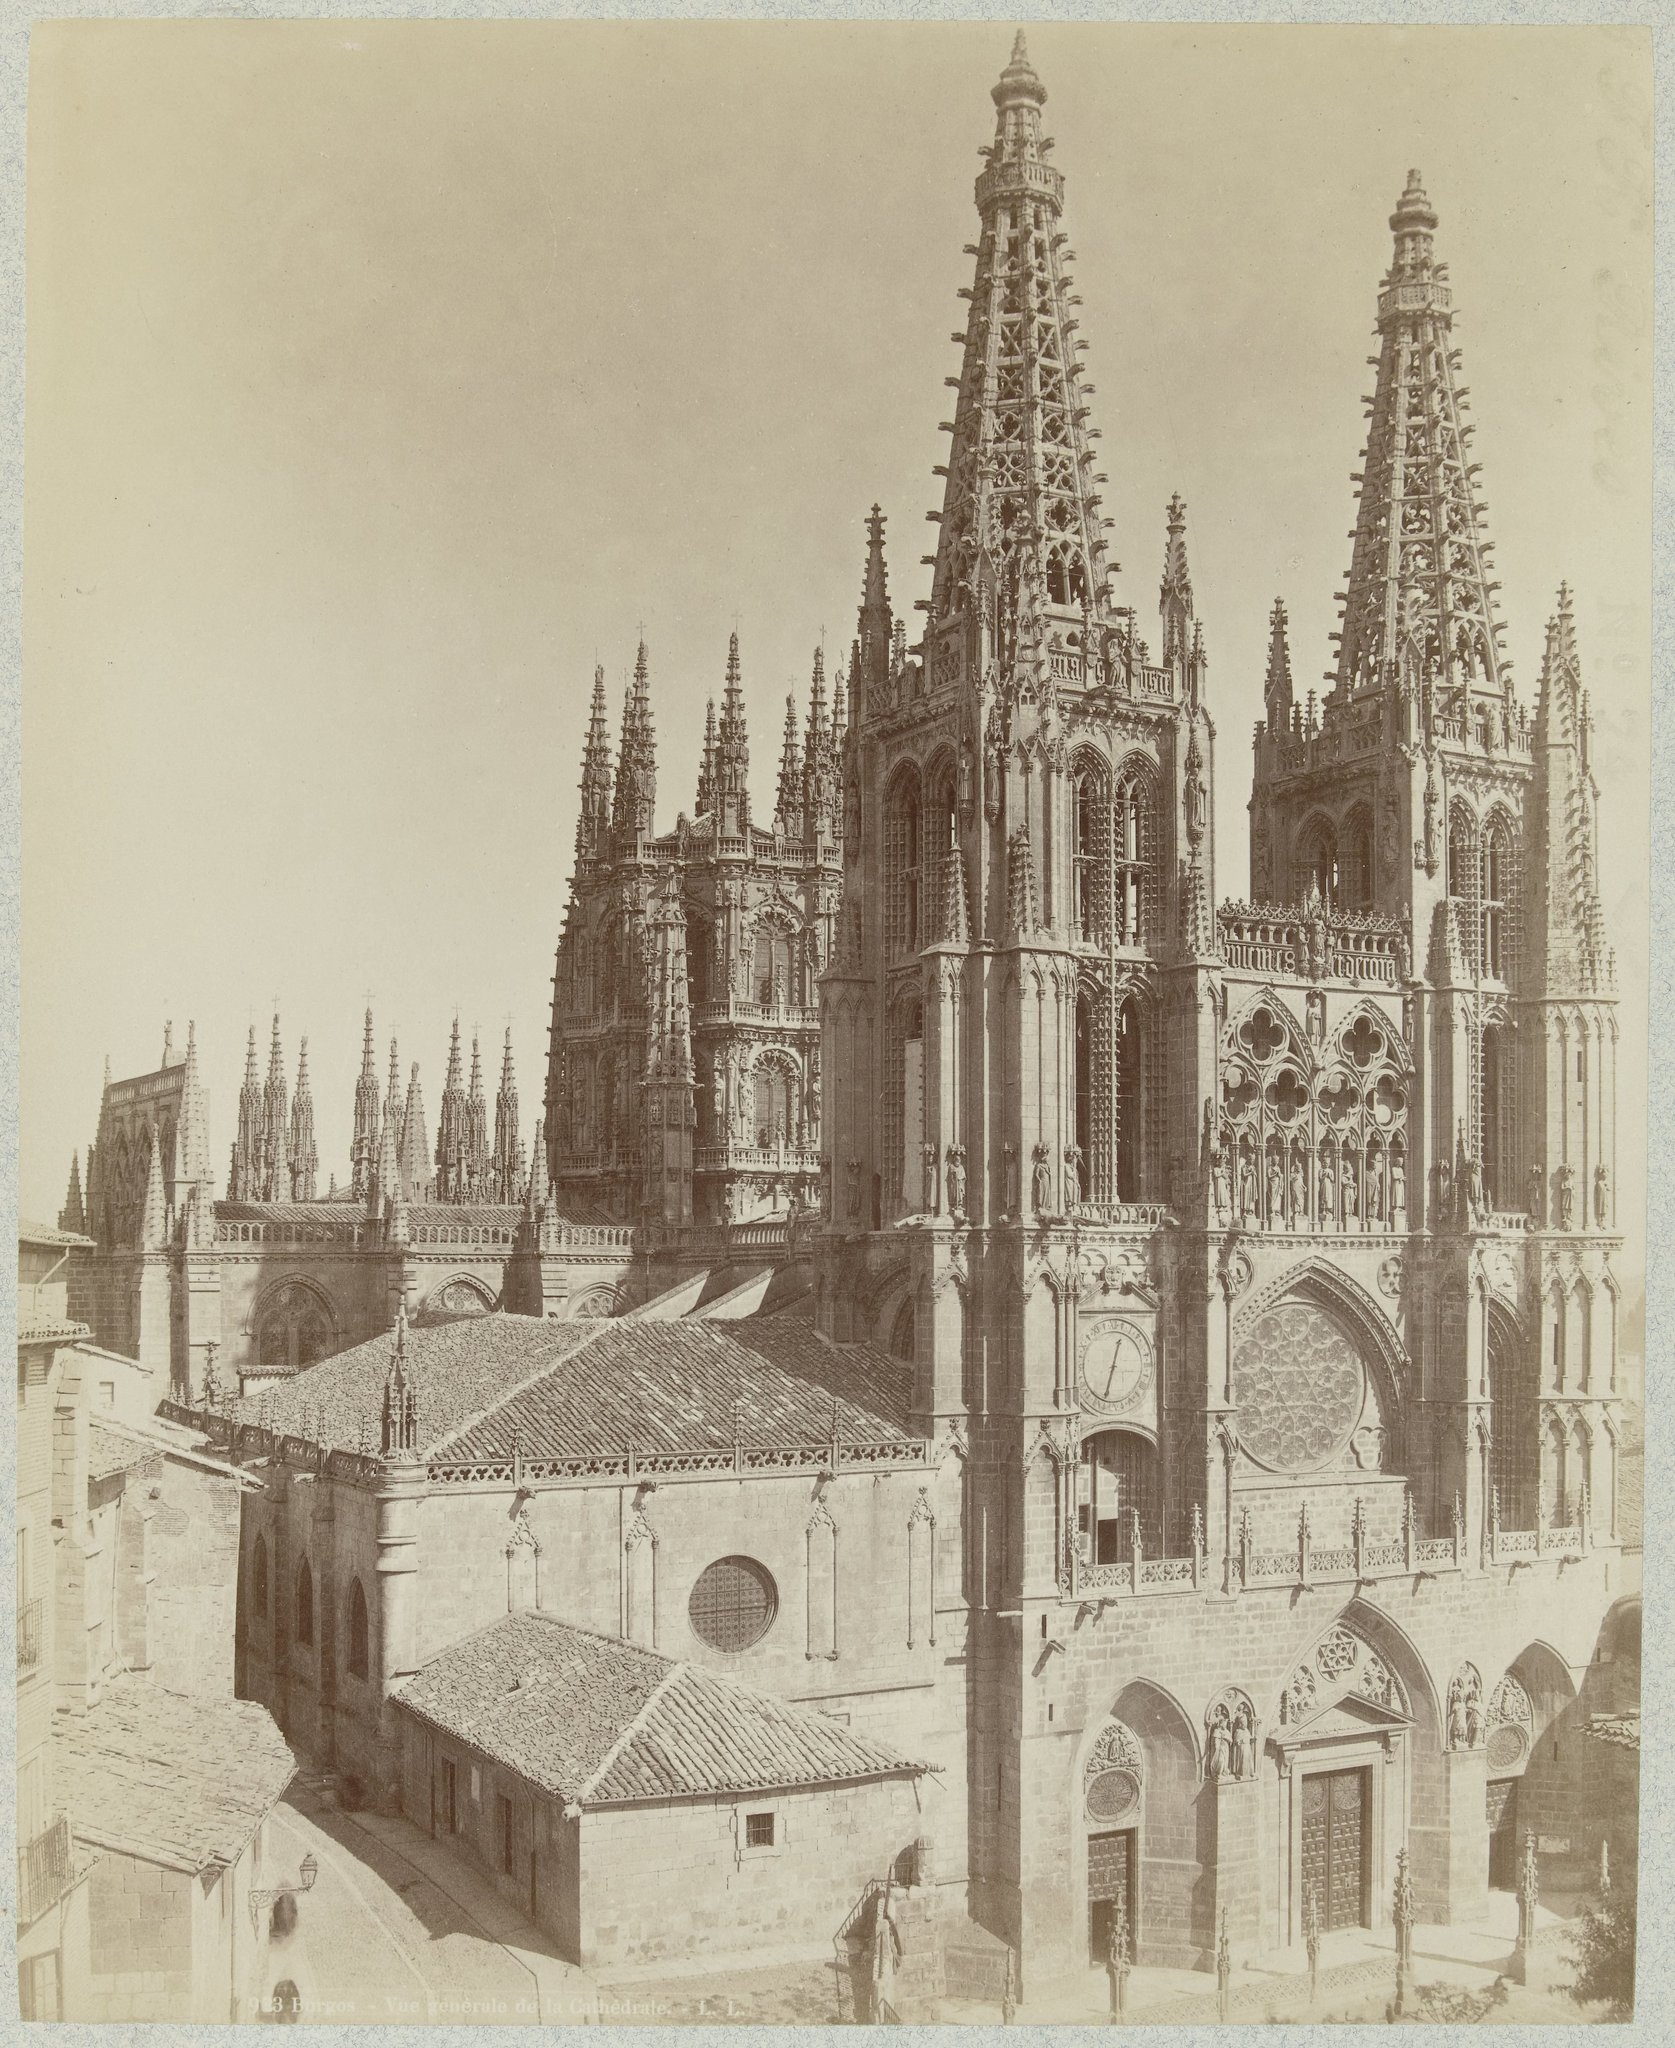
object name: photograph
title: Vue genérale de la Cathédrale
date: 1864-1920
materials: cardboard, paper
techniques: albumen print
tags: church (exterior)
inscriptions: inscription: ‘Burgos’, number: ‘933’